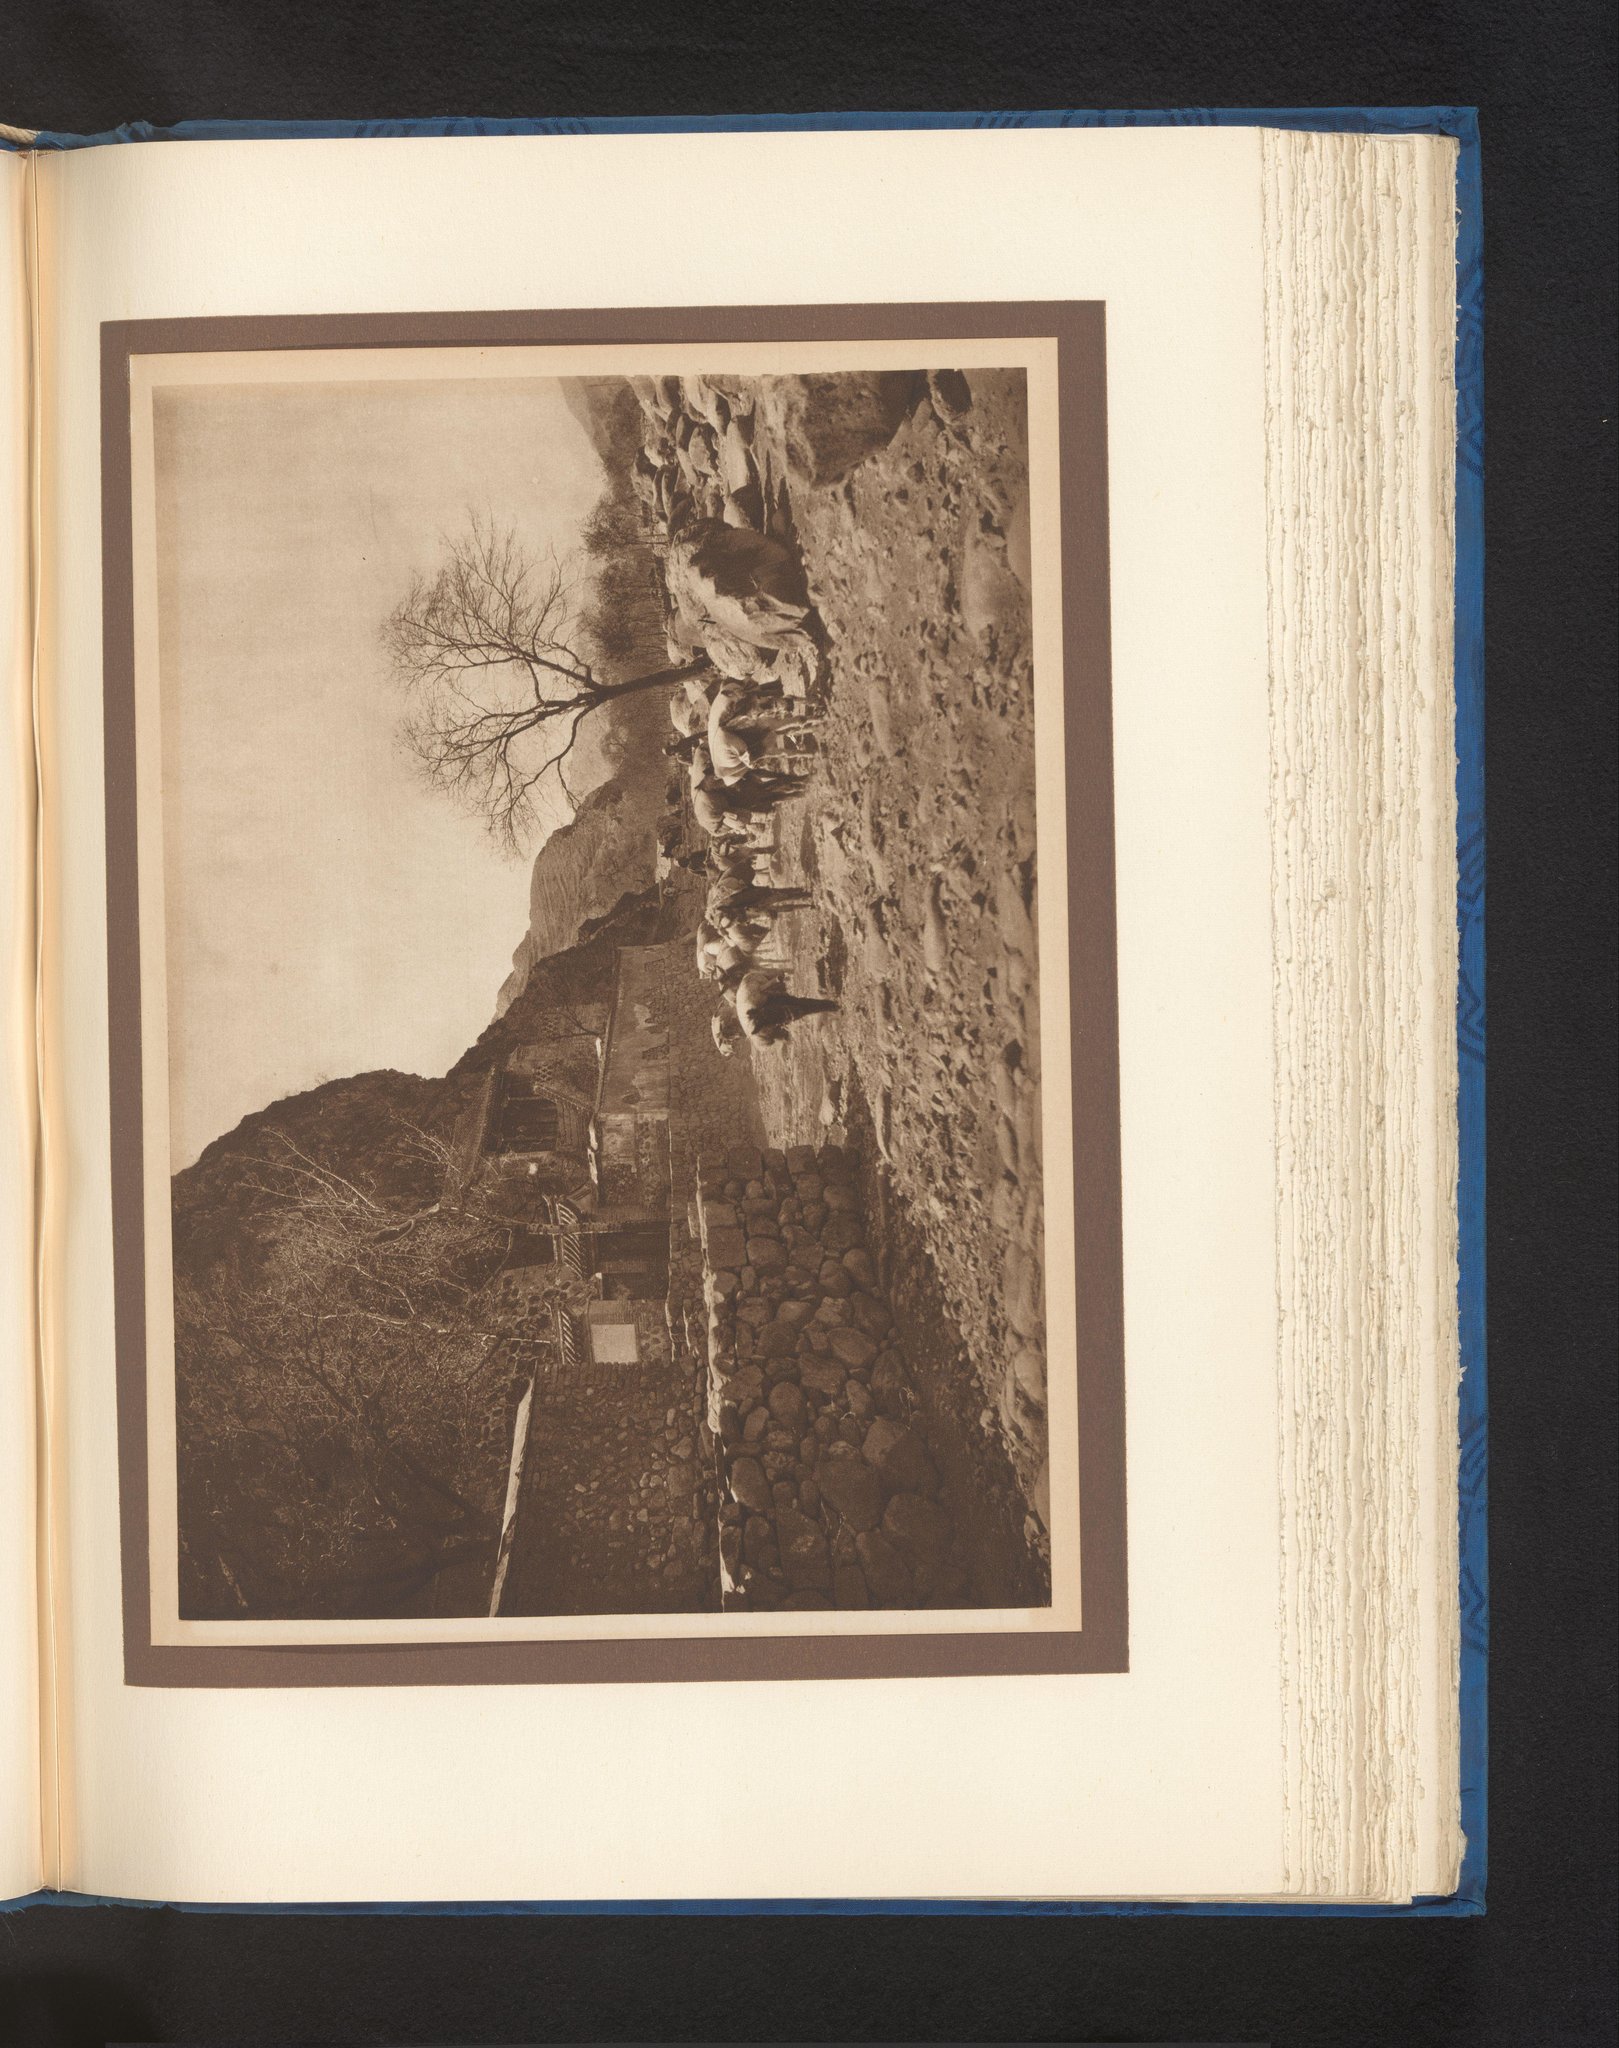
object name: photomechanical print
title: Ezels op een weg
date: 1915-1920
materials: paper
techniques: rotogravure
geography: beijing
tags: ass, donkey, road, path